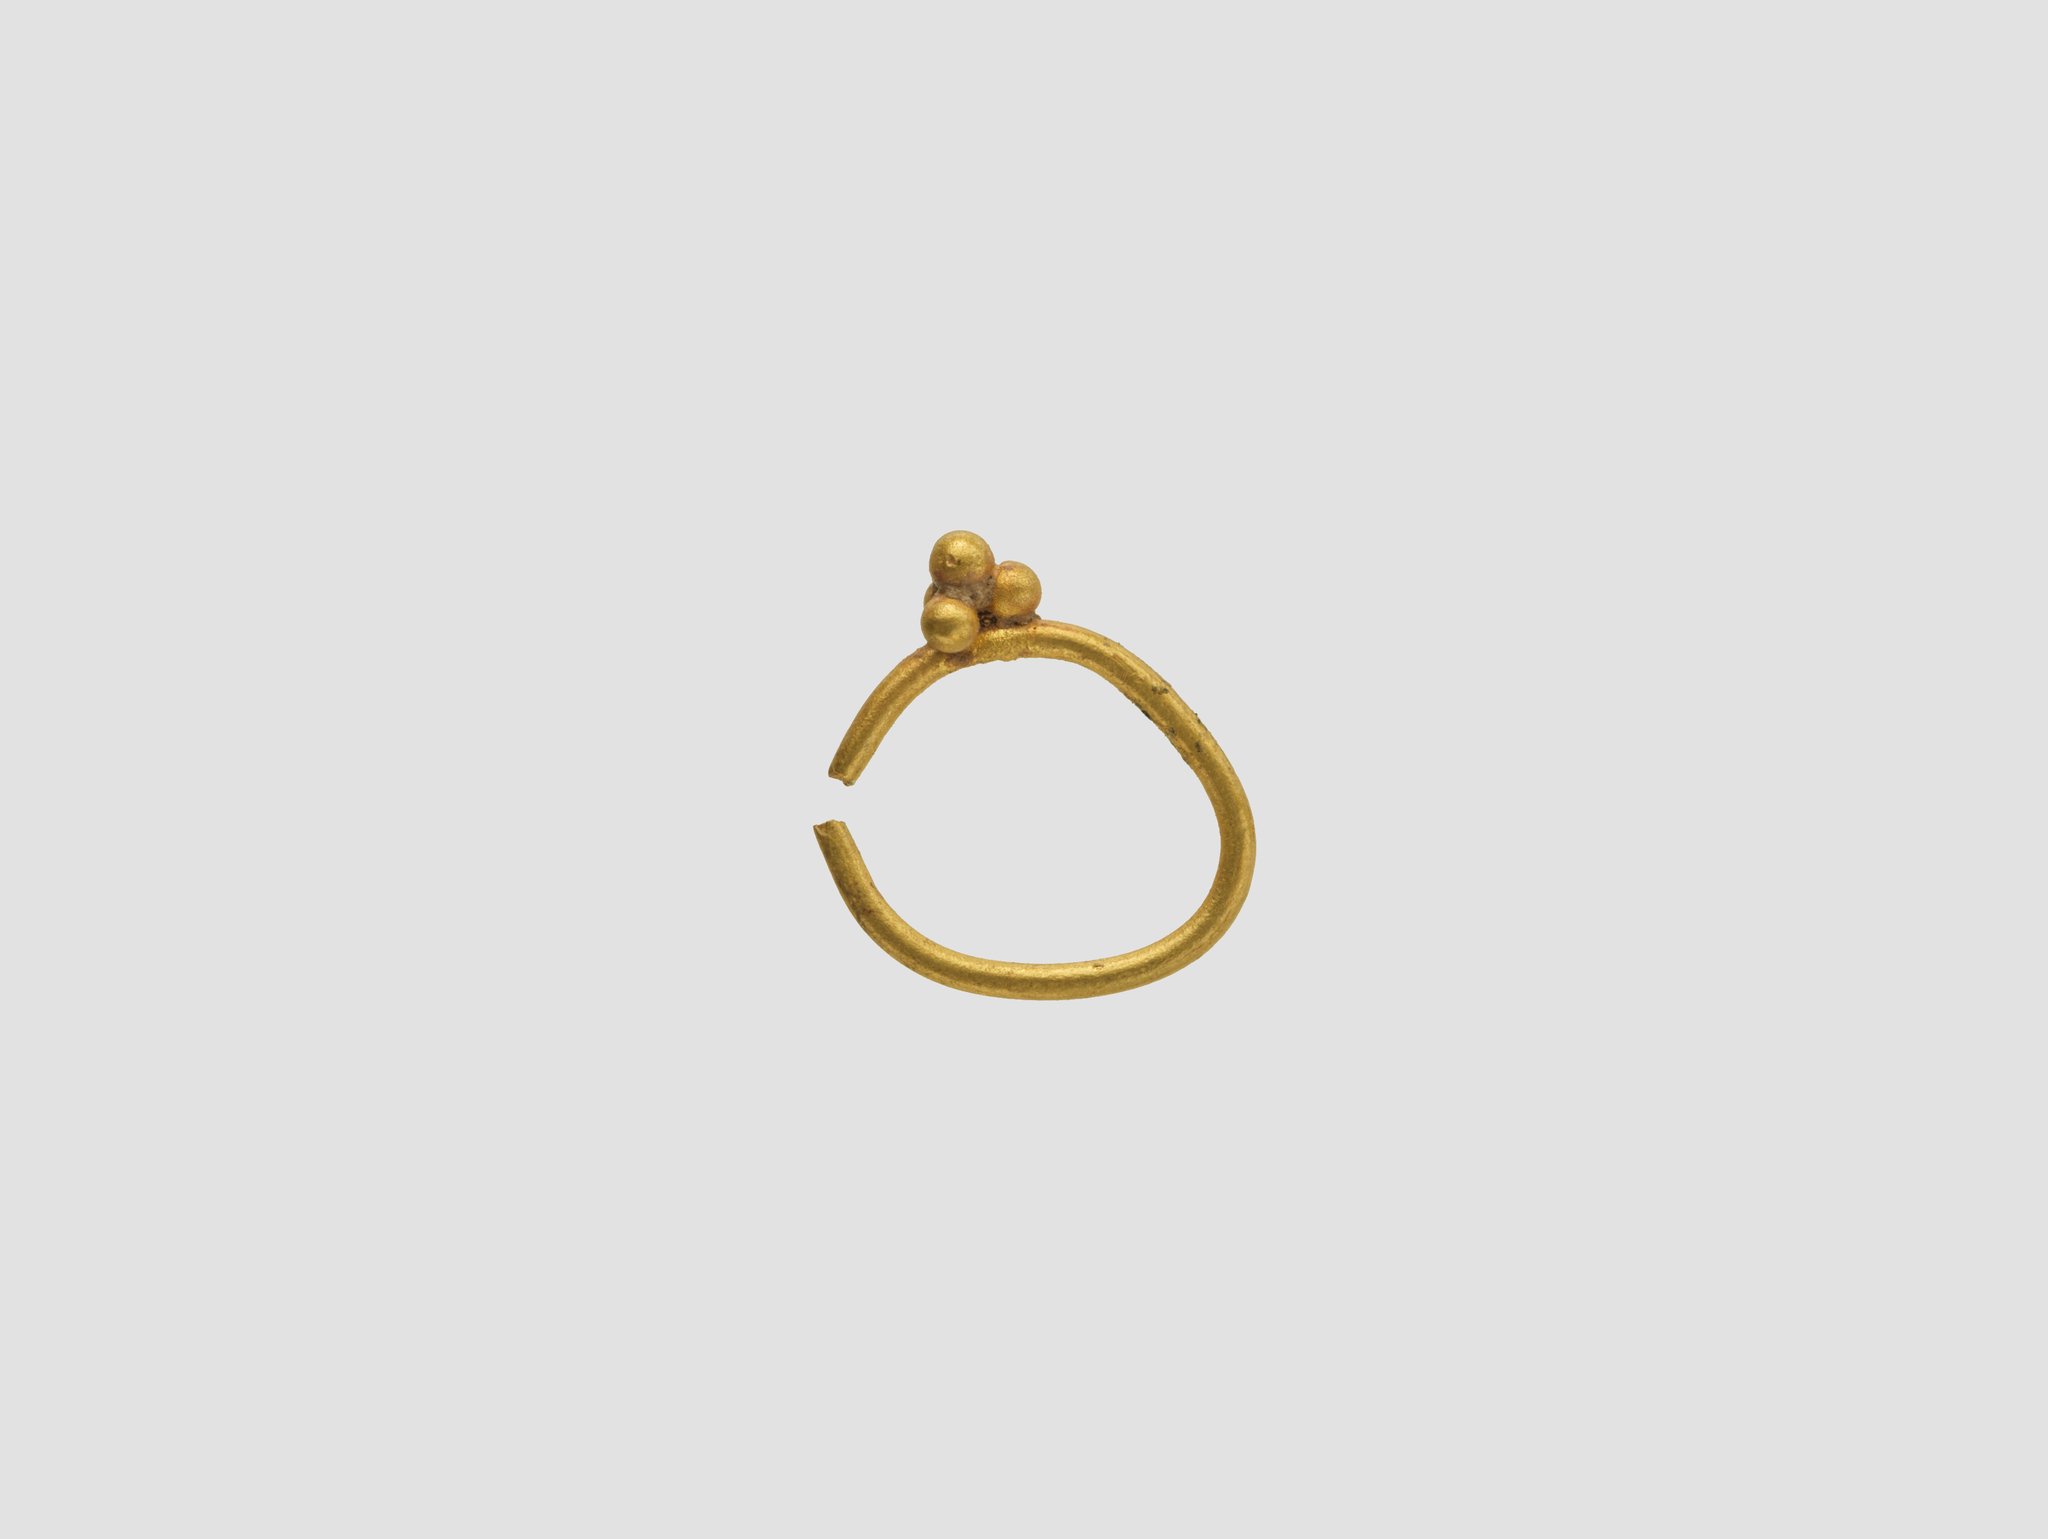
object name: earring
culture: sasanian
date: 201-700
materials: gold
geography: iran